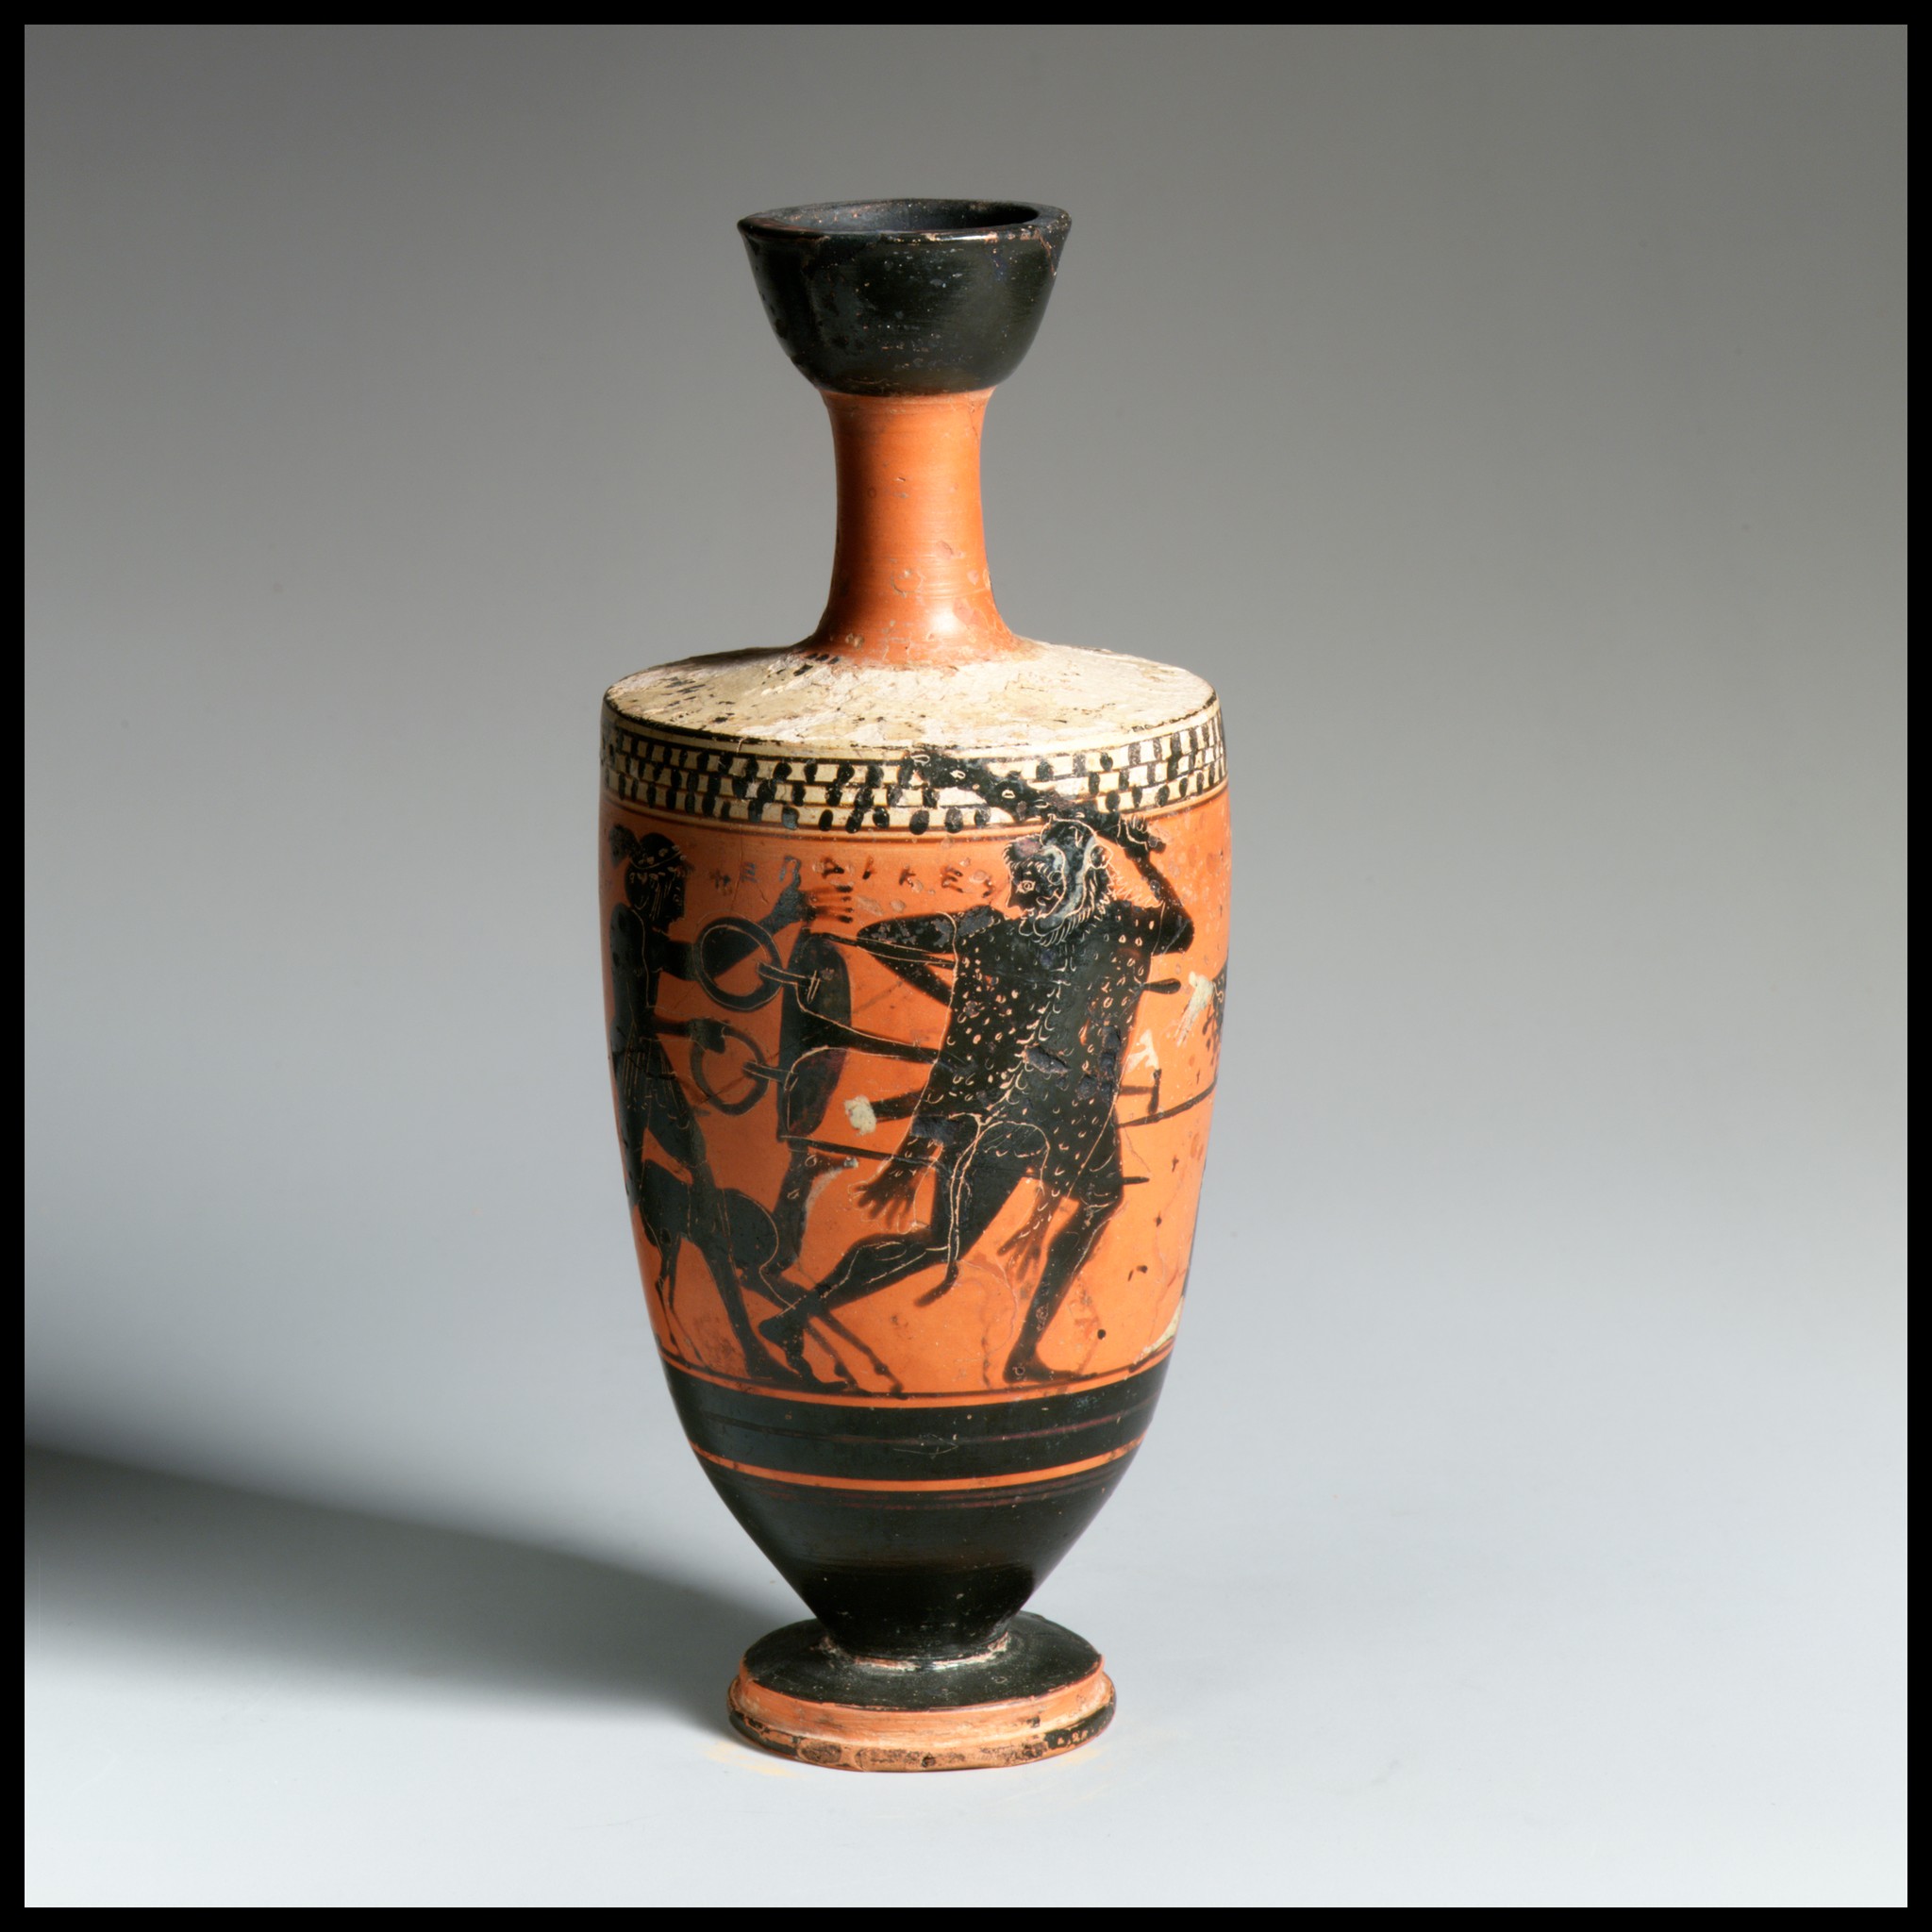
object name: lekythos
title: Terracotta lekythos (oil flask)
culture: greek, attic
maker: sappho painter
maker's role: artist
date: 500-490 BCE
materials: terracotta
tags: animals,apollo,artemis,athena